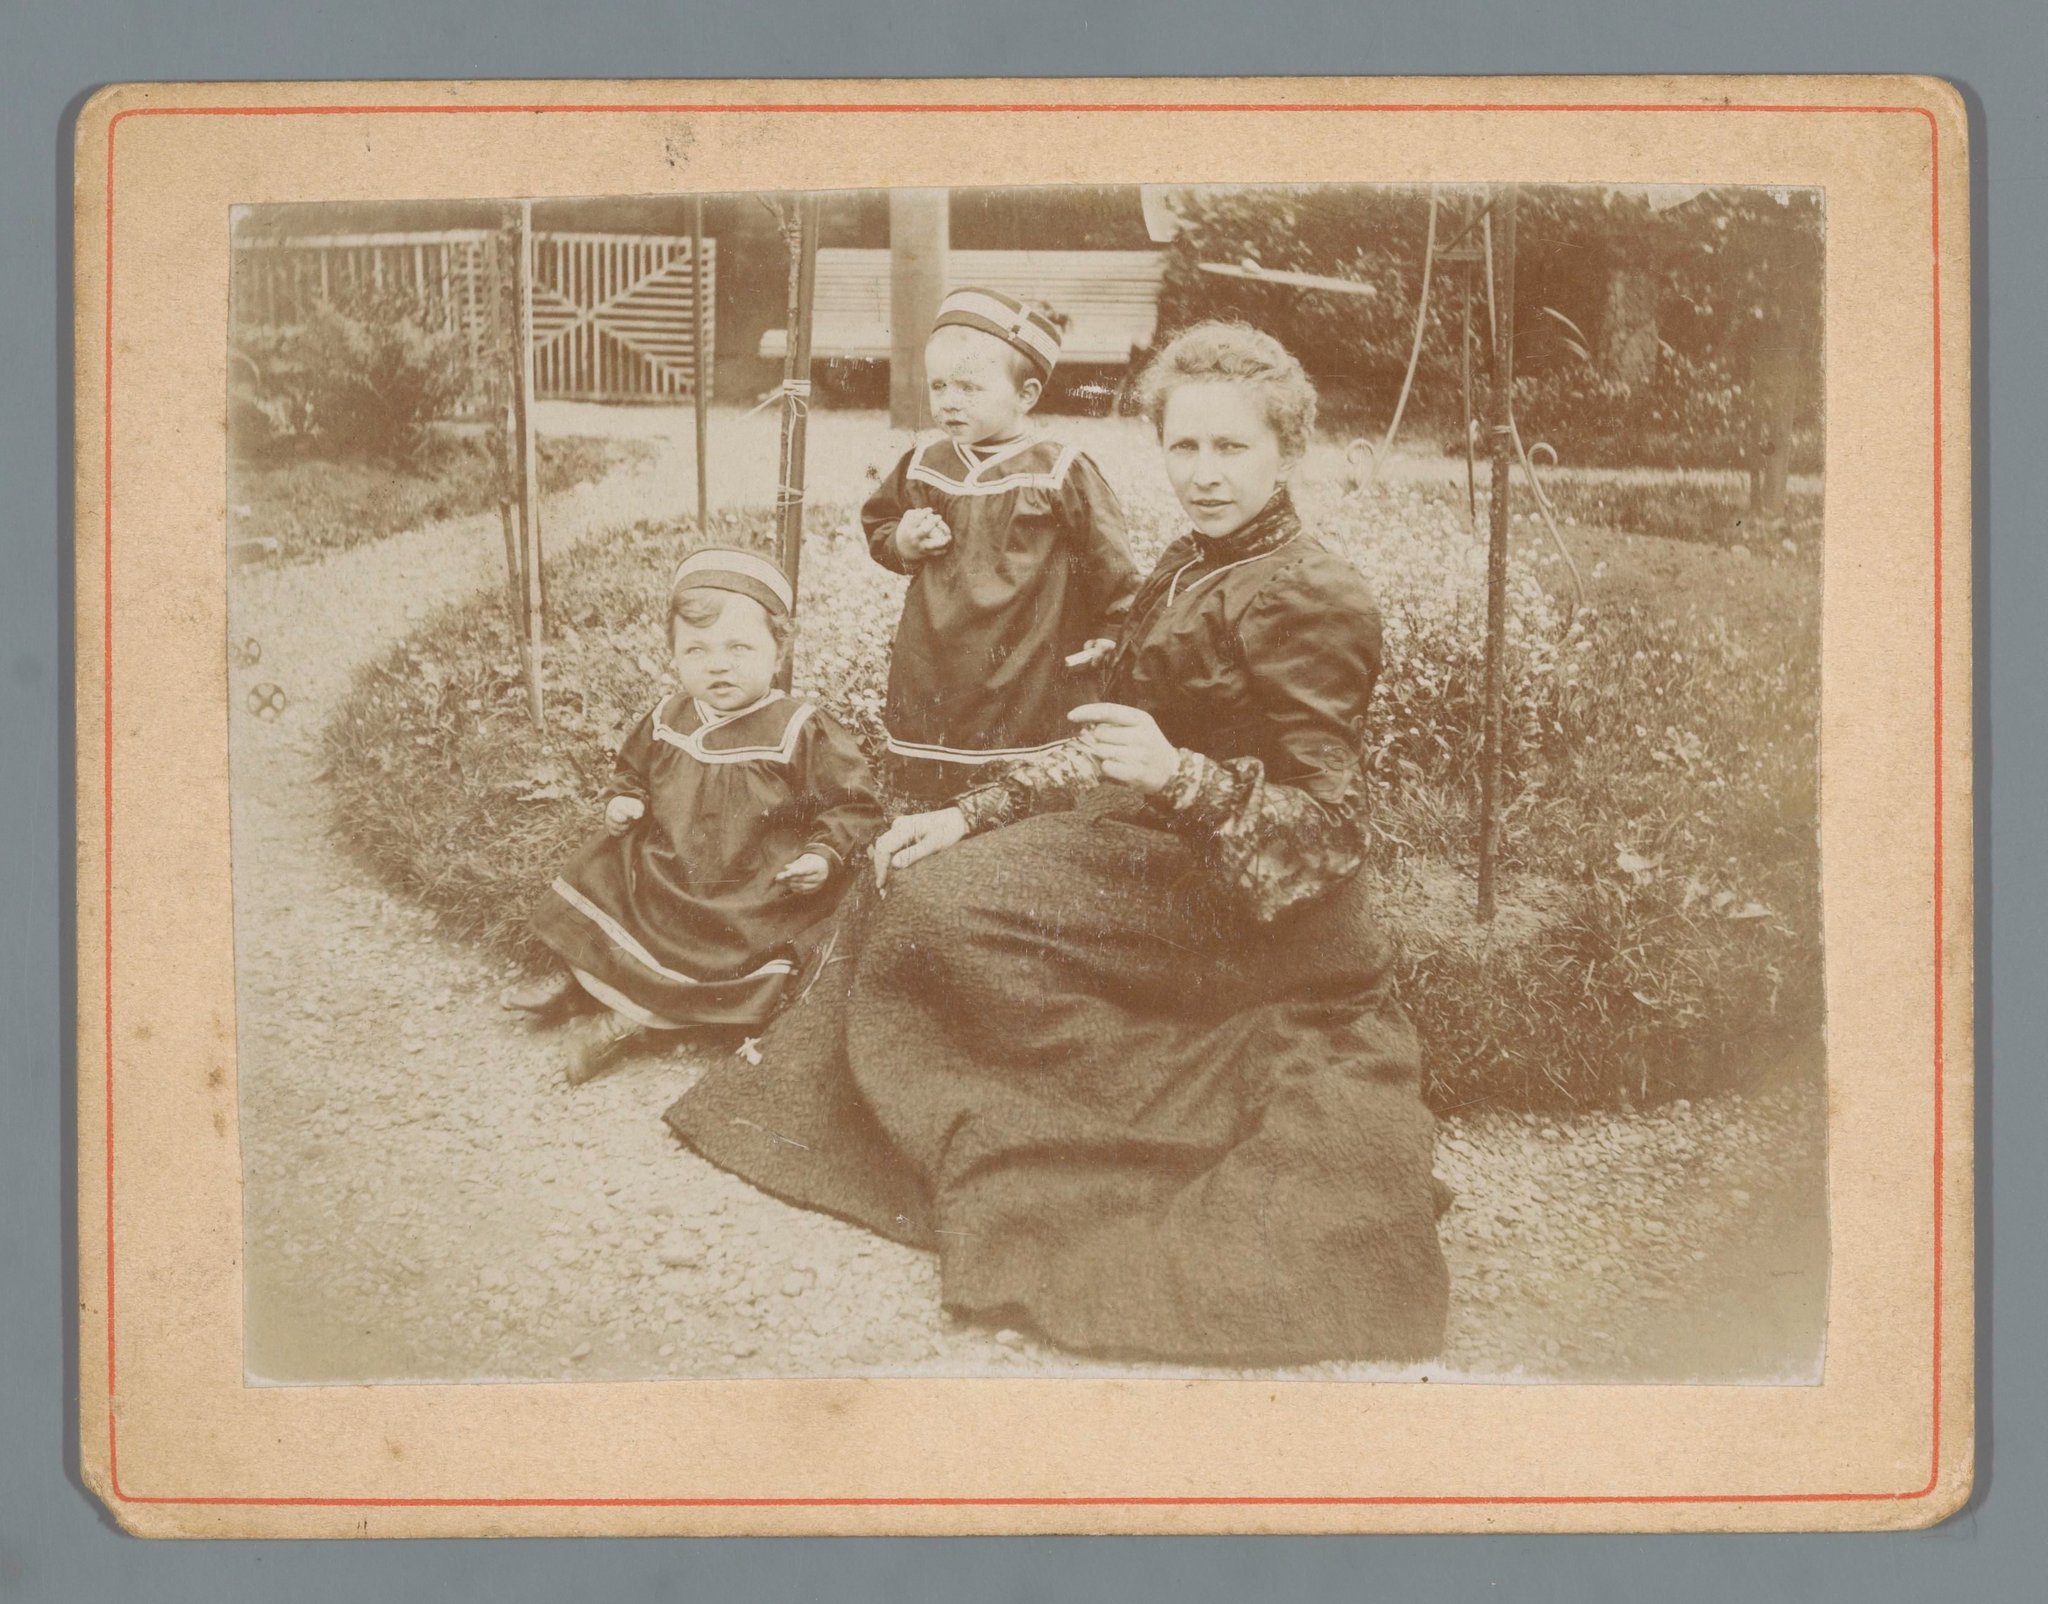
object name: photograph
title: Portret van Wilhelmina Gerarda Hoogendijk en haar kinderen Ad en Johanna van der Kop in een tuin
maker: willem carel van der kop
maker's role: amateurfotograaf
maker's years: 1869-1924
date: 1902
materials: cardboard, photographic support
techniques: collodion silver print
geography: schoonhoven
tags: sculptor, adrianus johannes van der kop (ad), mother and child(ren), woman and child(ren) (family group), backyard